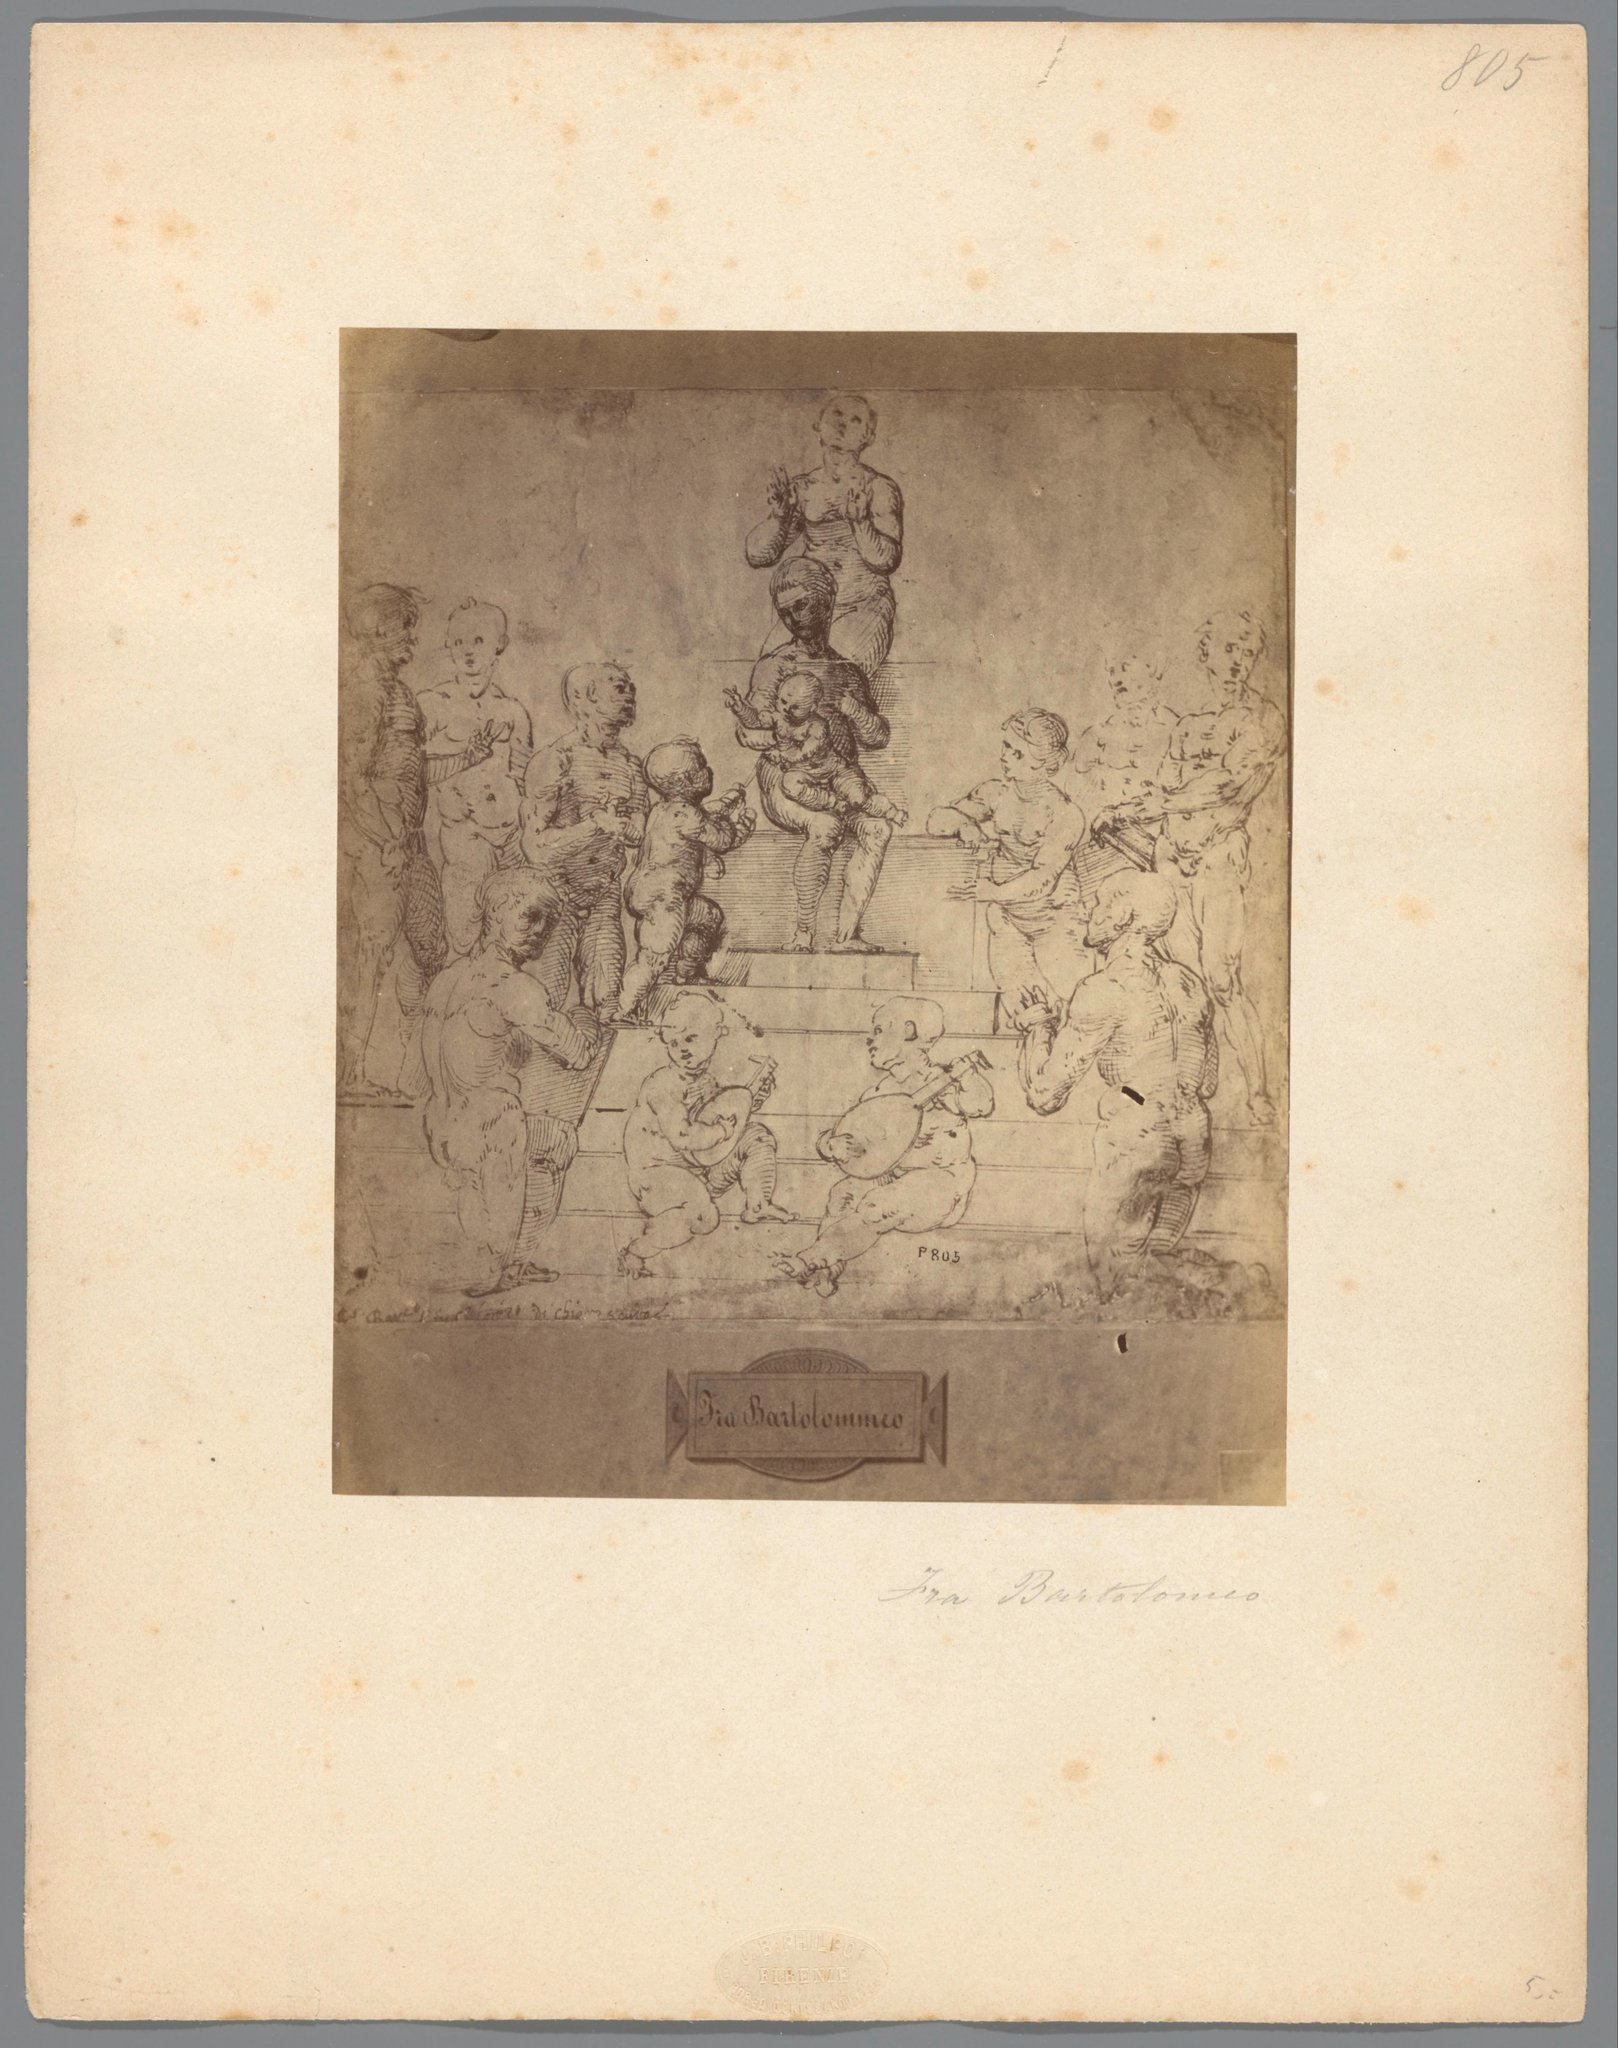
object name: reproduction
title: Fotoreproductie van een tekening van Fra Bartolommeo in de Galleria degli Uffizi in Florence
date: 1851-1878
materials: cardboard, paper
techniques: albumen print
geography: florence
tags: drawing, sketch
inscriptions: inscription: ‘5,=’, number: ‘805’, number: ‘P805’